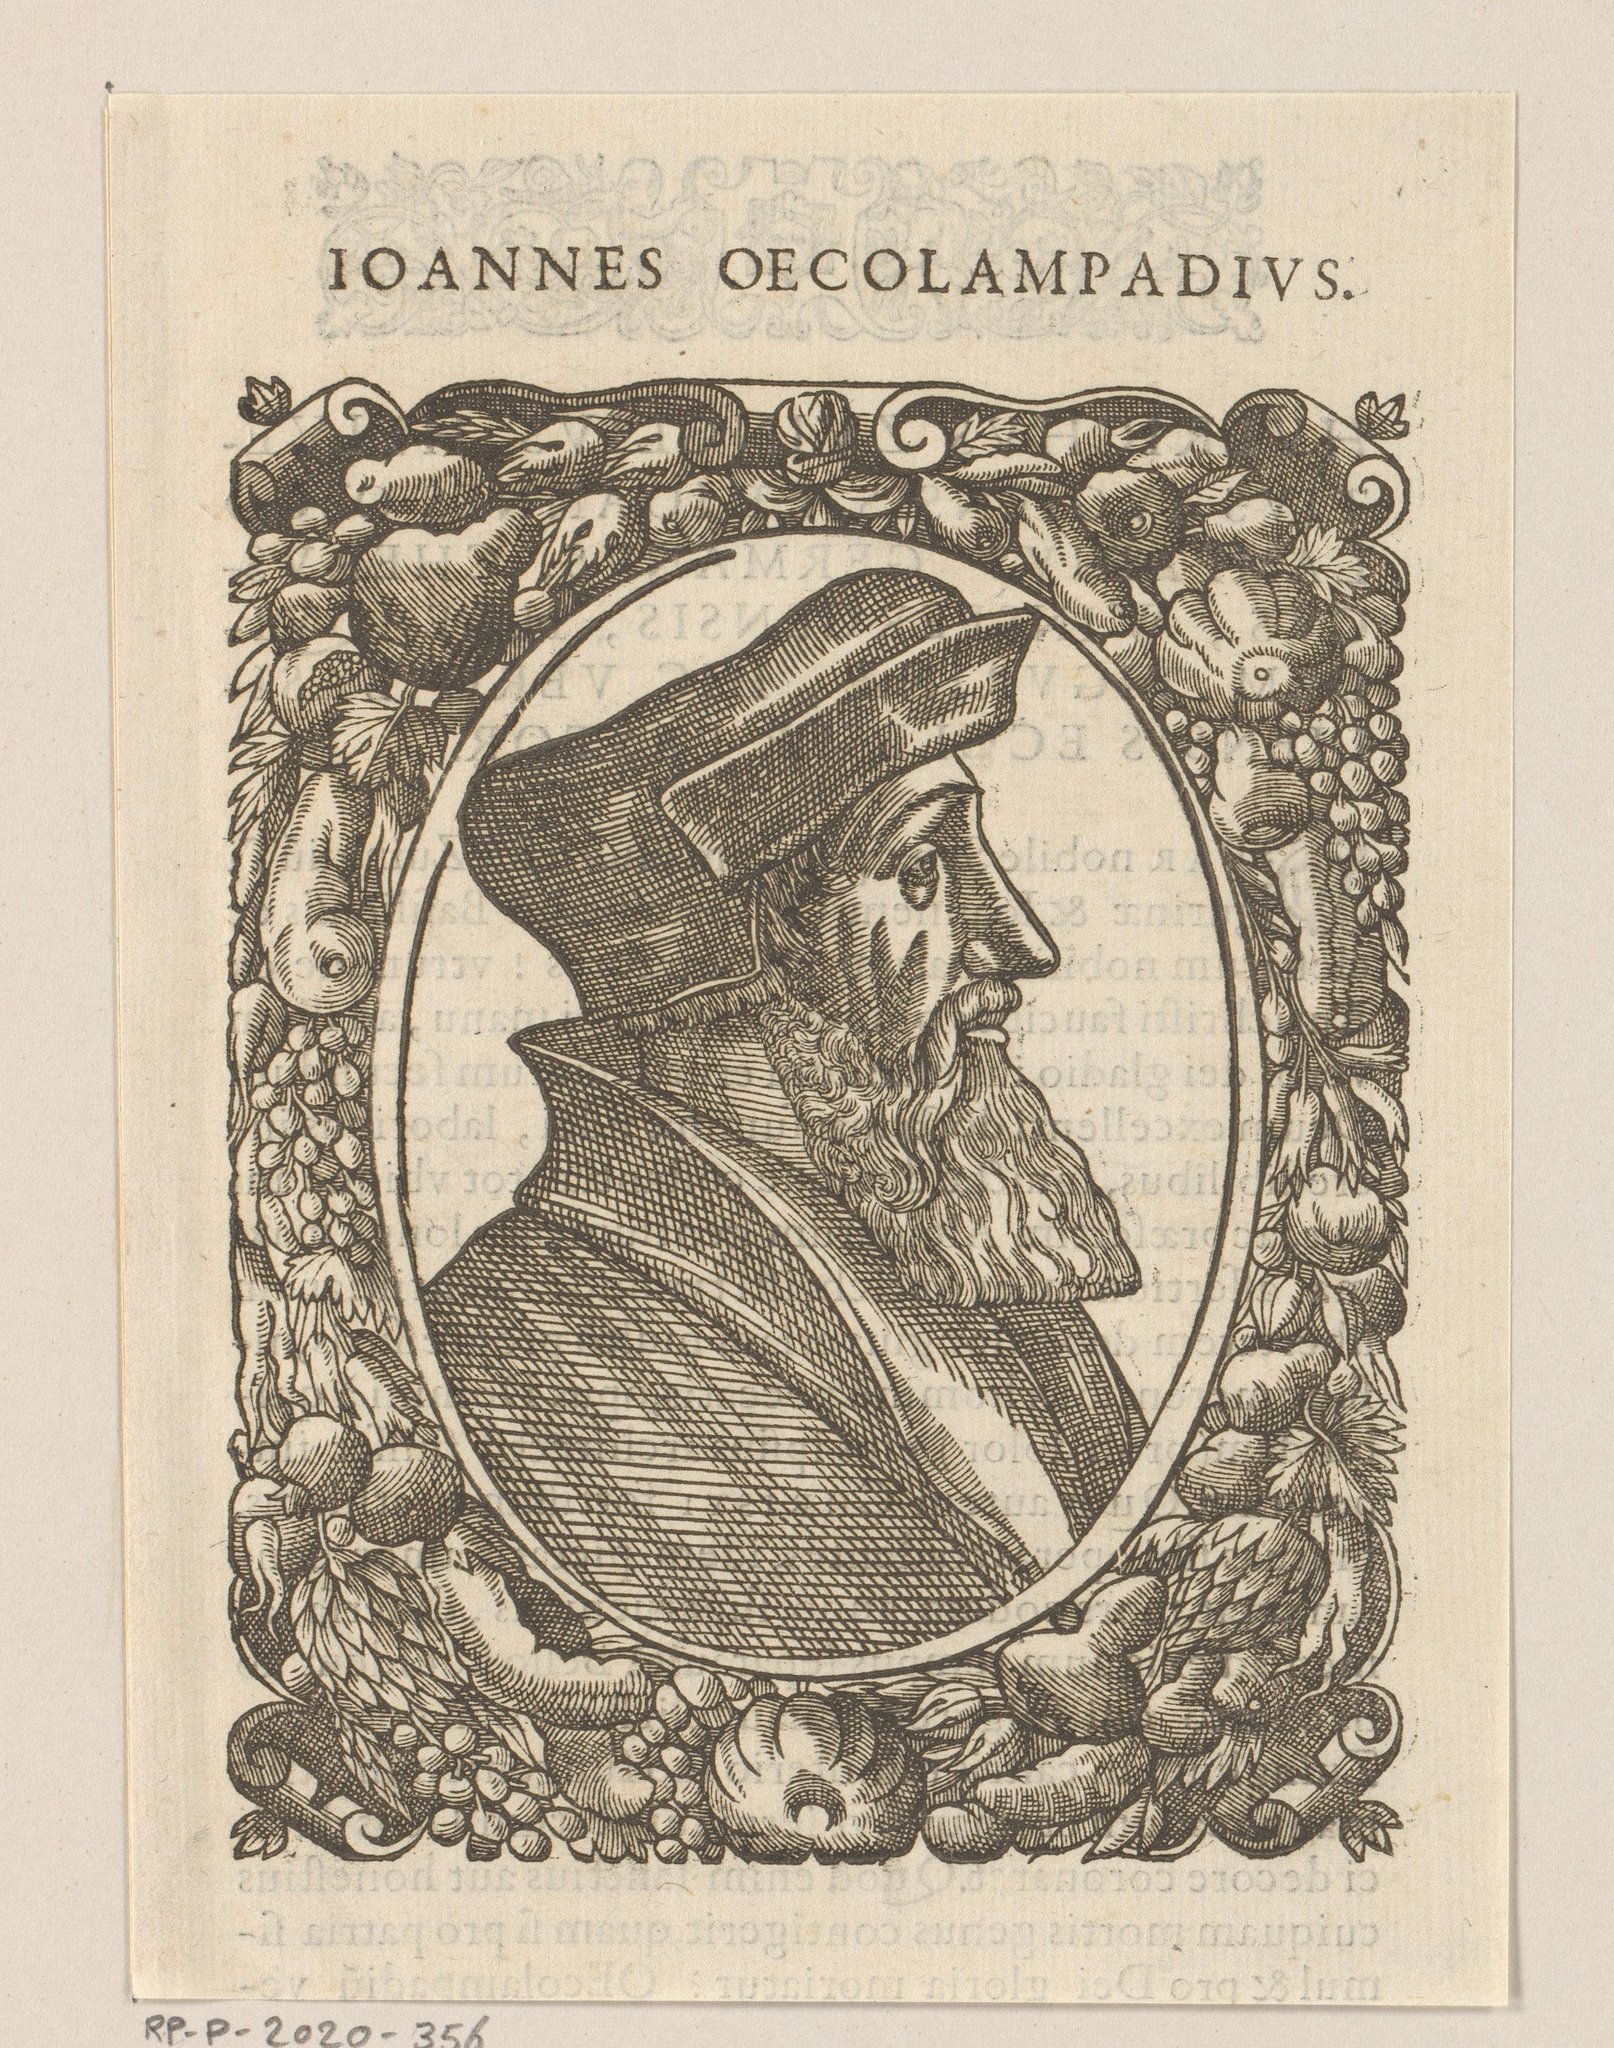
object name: print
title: Portret van Johannes Oecolampadius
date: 1580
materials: paper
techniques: letterpress printing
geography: geneva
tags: theologian, historical persons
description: Prent uit: Beze, Theodore de. Icones id est verae imagines virorum doctrina simul et pietate illustrium (...). Genève: Jean de Laon, 1580. Prent ook gebruikt in: Beze, Theodore de. Les vrais pourtraits des hommes illustres en piete et doctrine (...). Genève: Jean de Laon, 1581.